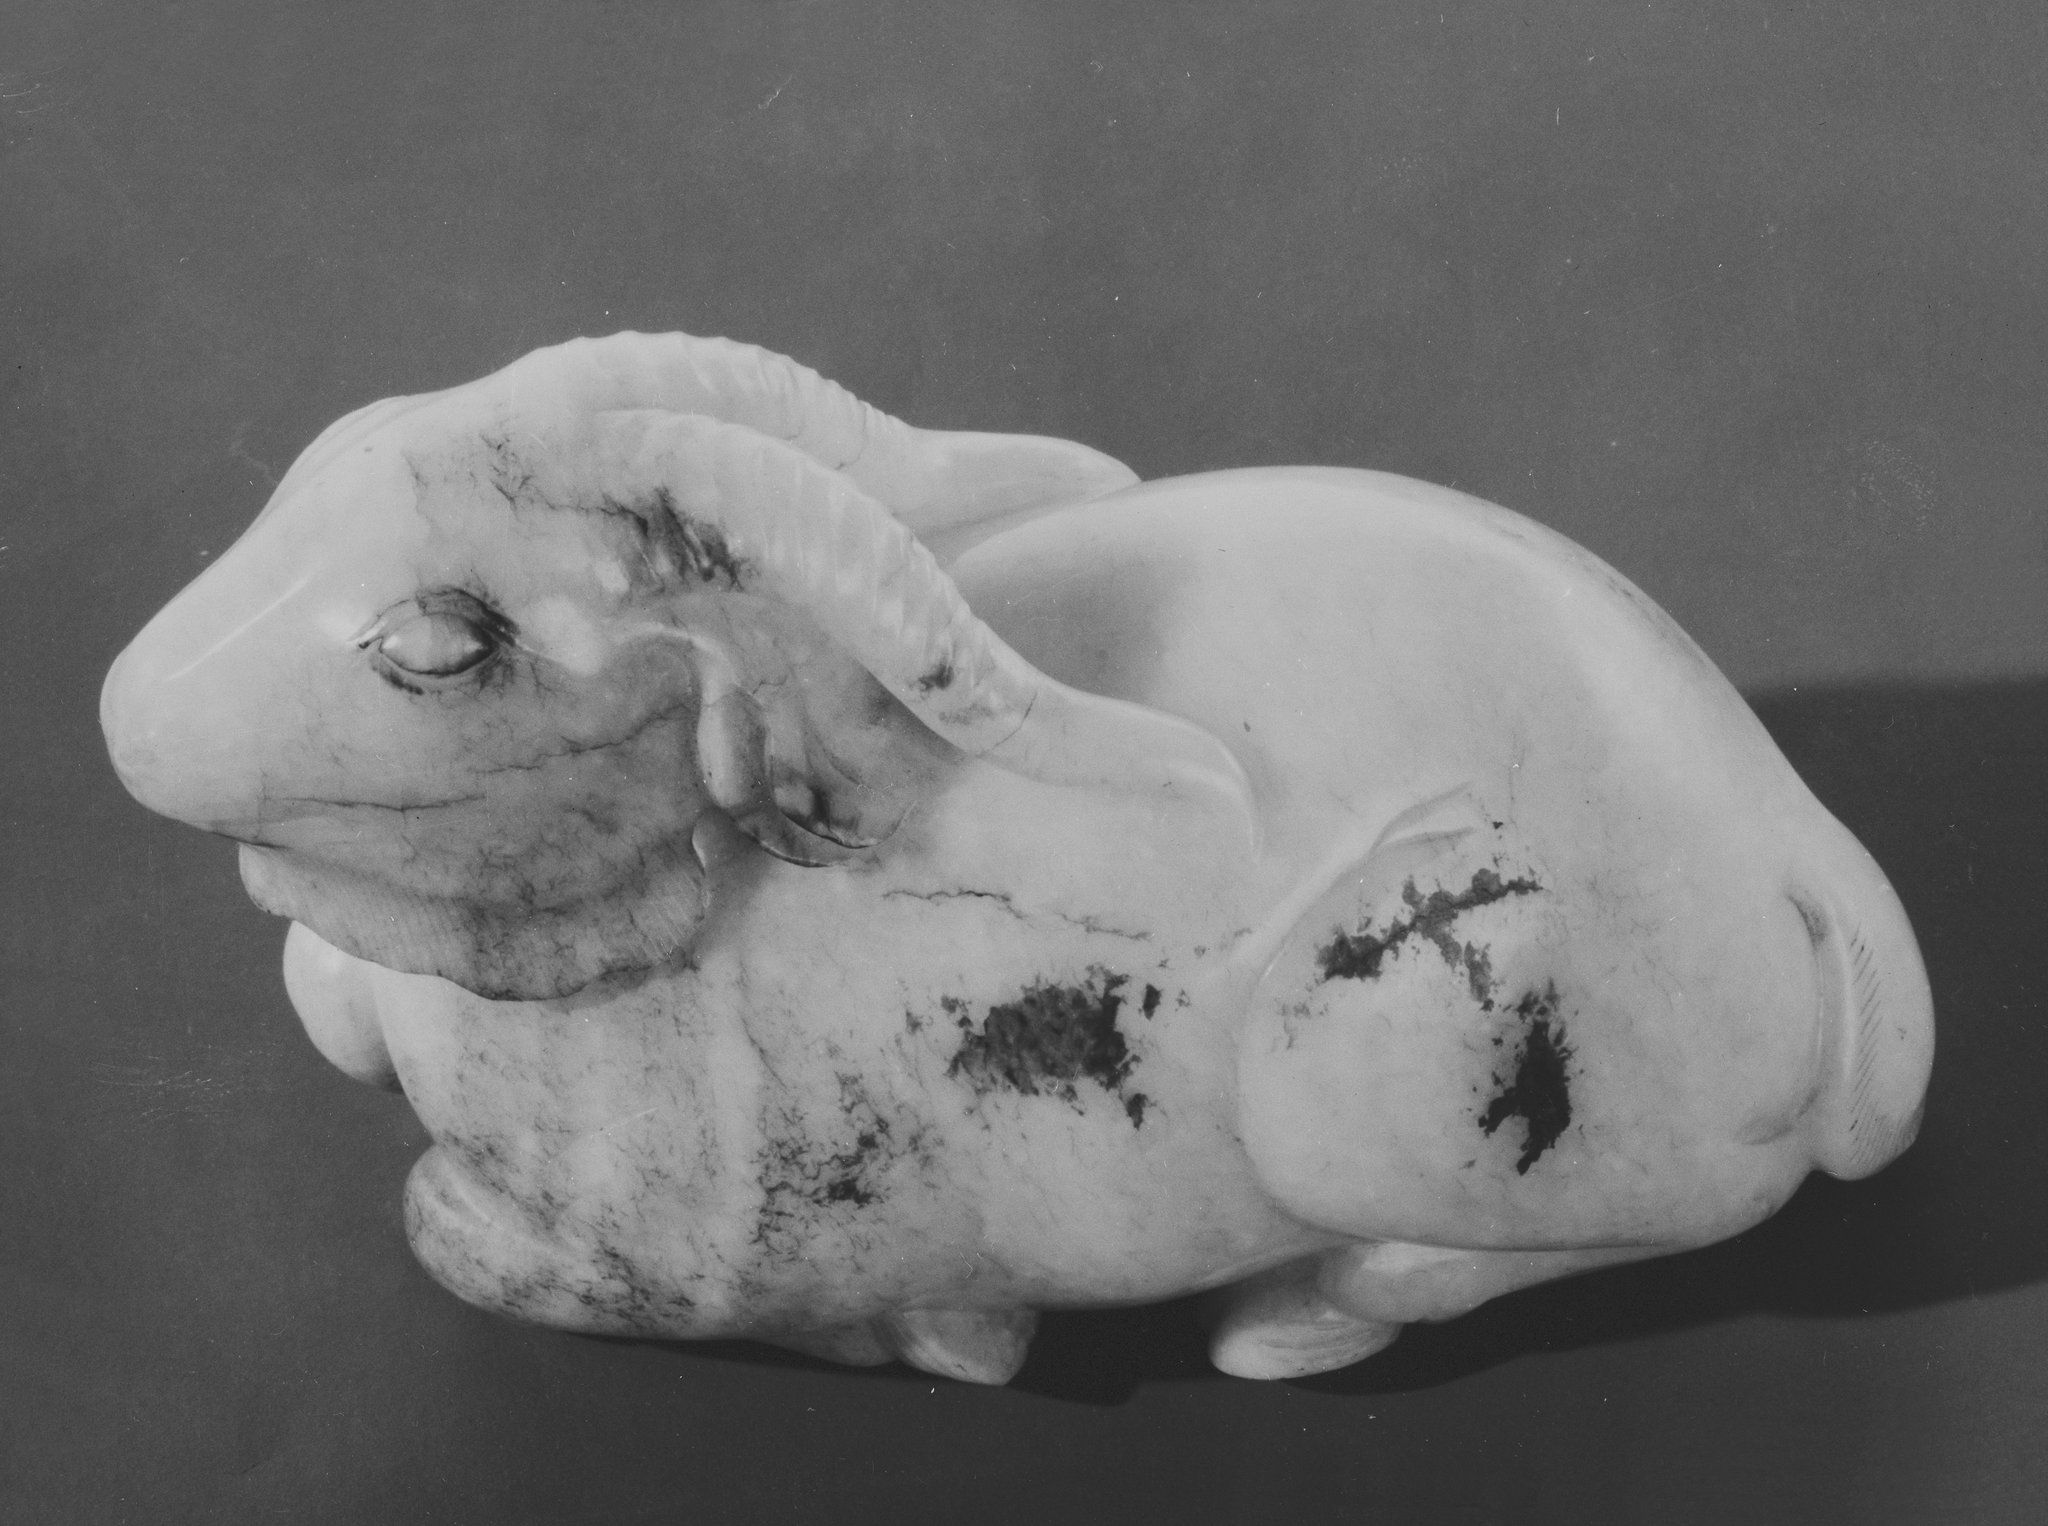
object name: figurine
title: Goat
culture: chinese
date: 1701-1800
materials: jade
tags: goats